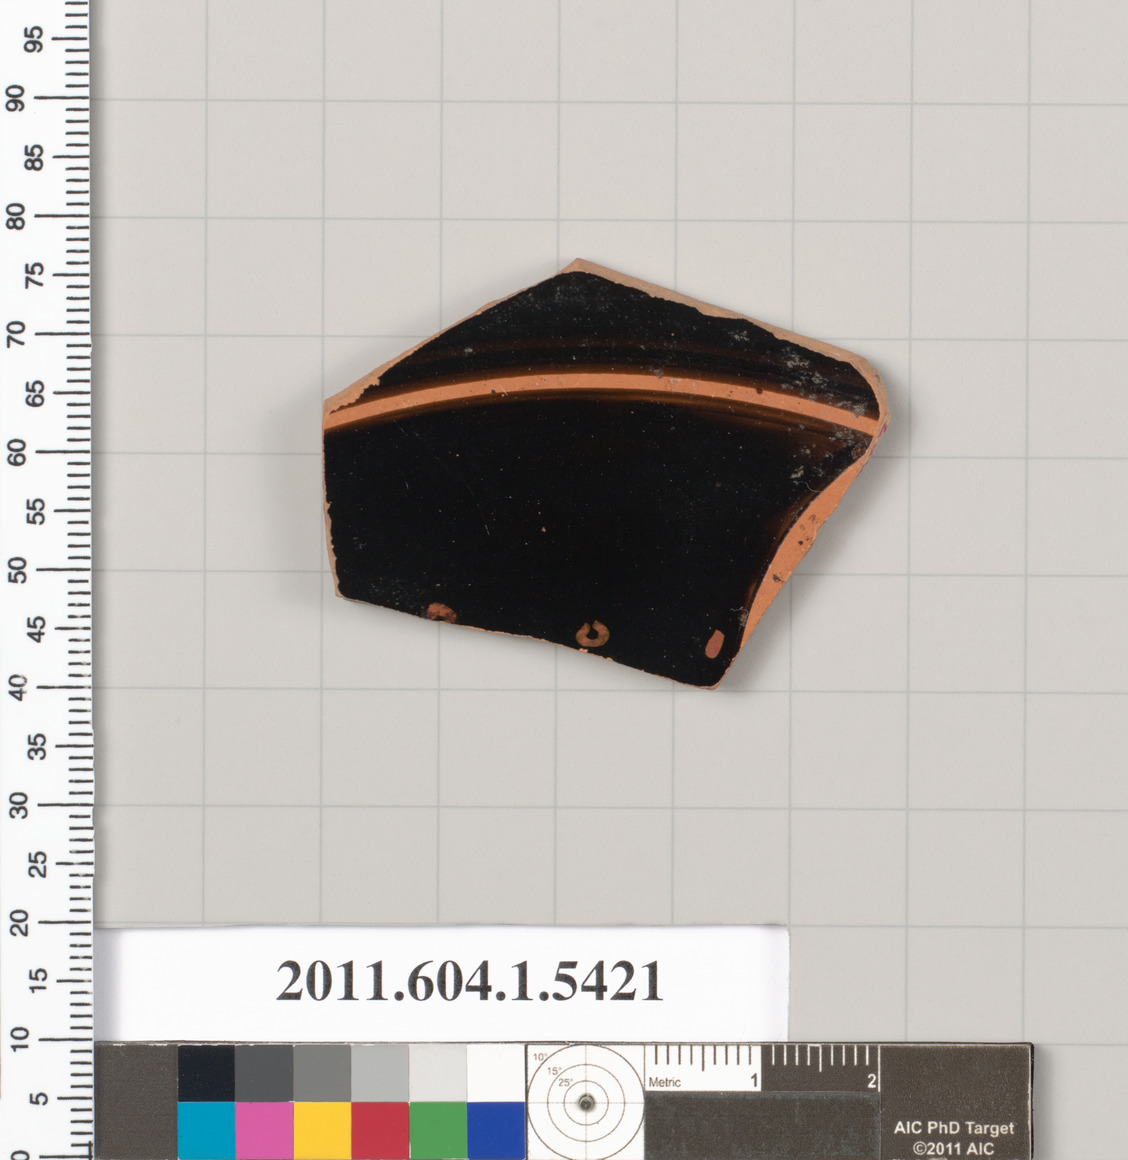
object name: kylix fragment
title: Terracotta fragment of a kylix (drinking cup)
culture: greek, attic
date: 500-480 BCE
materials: terracotta